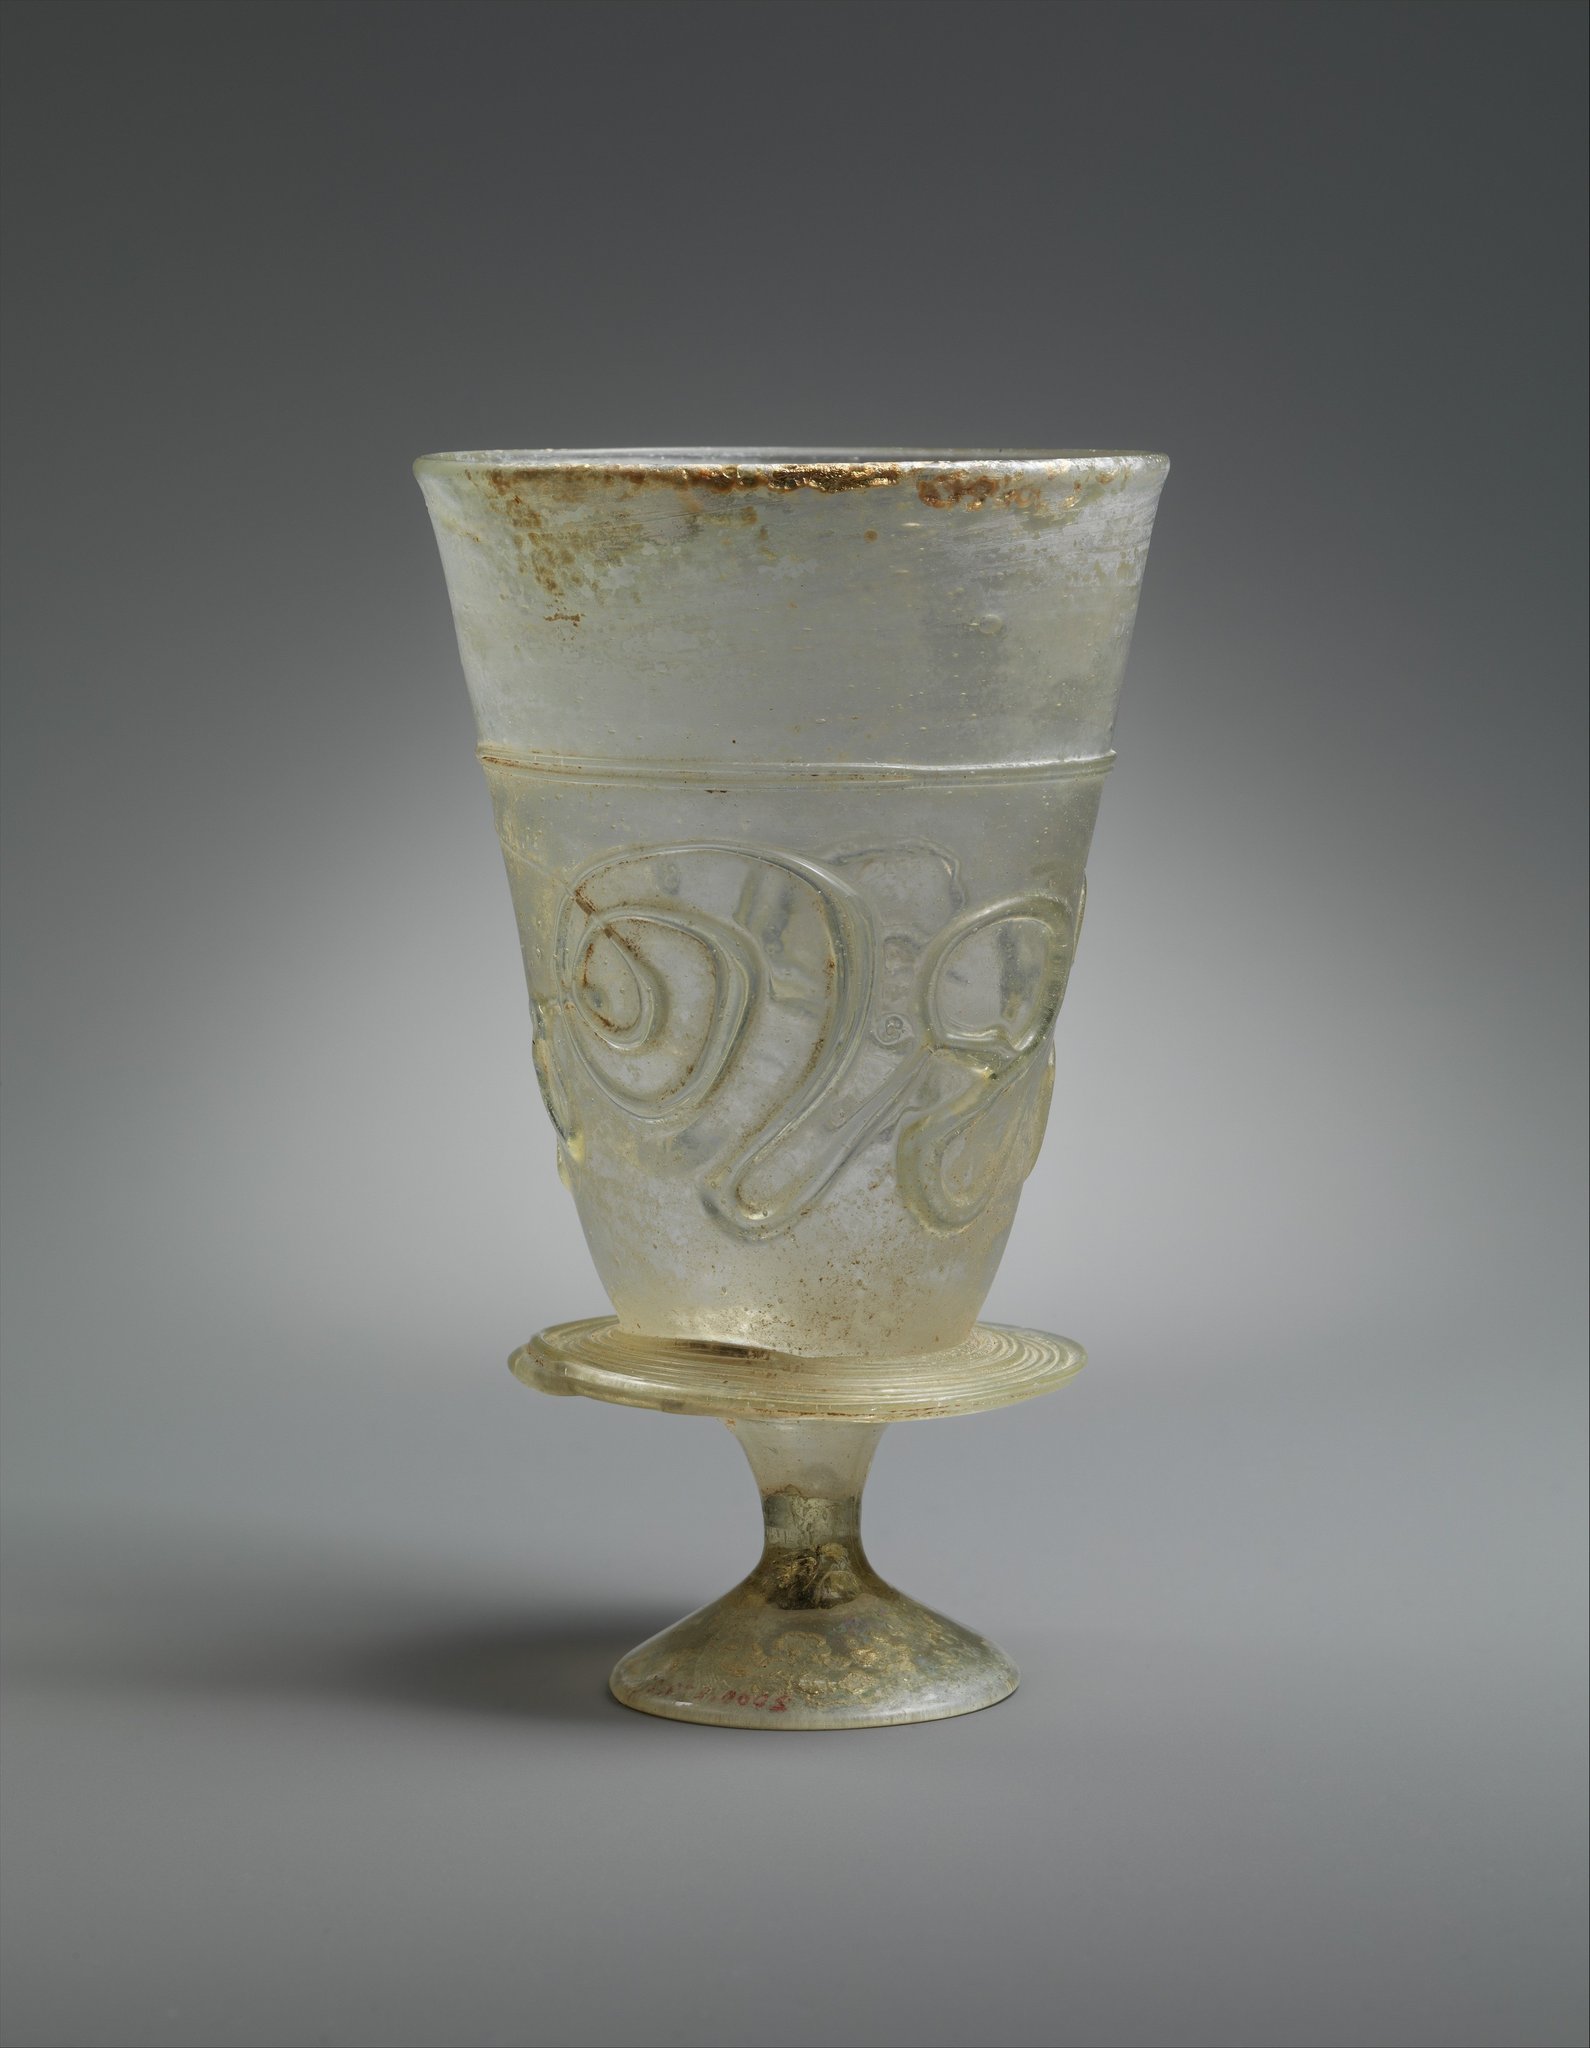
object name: goblet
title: Goblet with Applied Decoration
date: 1001-1133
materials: glass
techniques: glassblowing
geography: iran